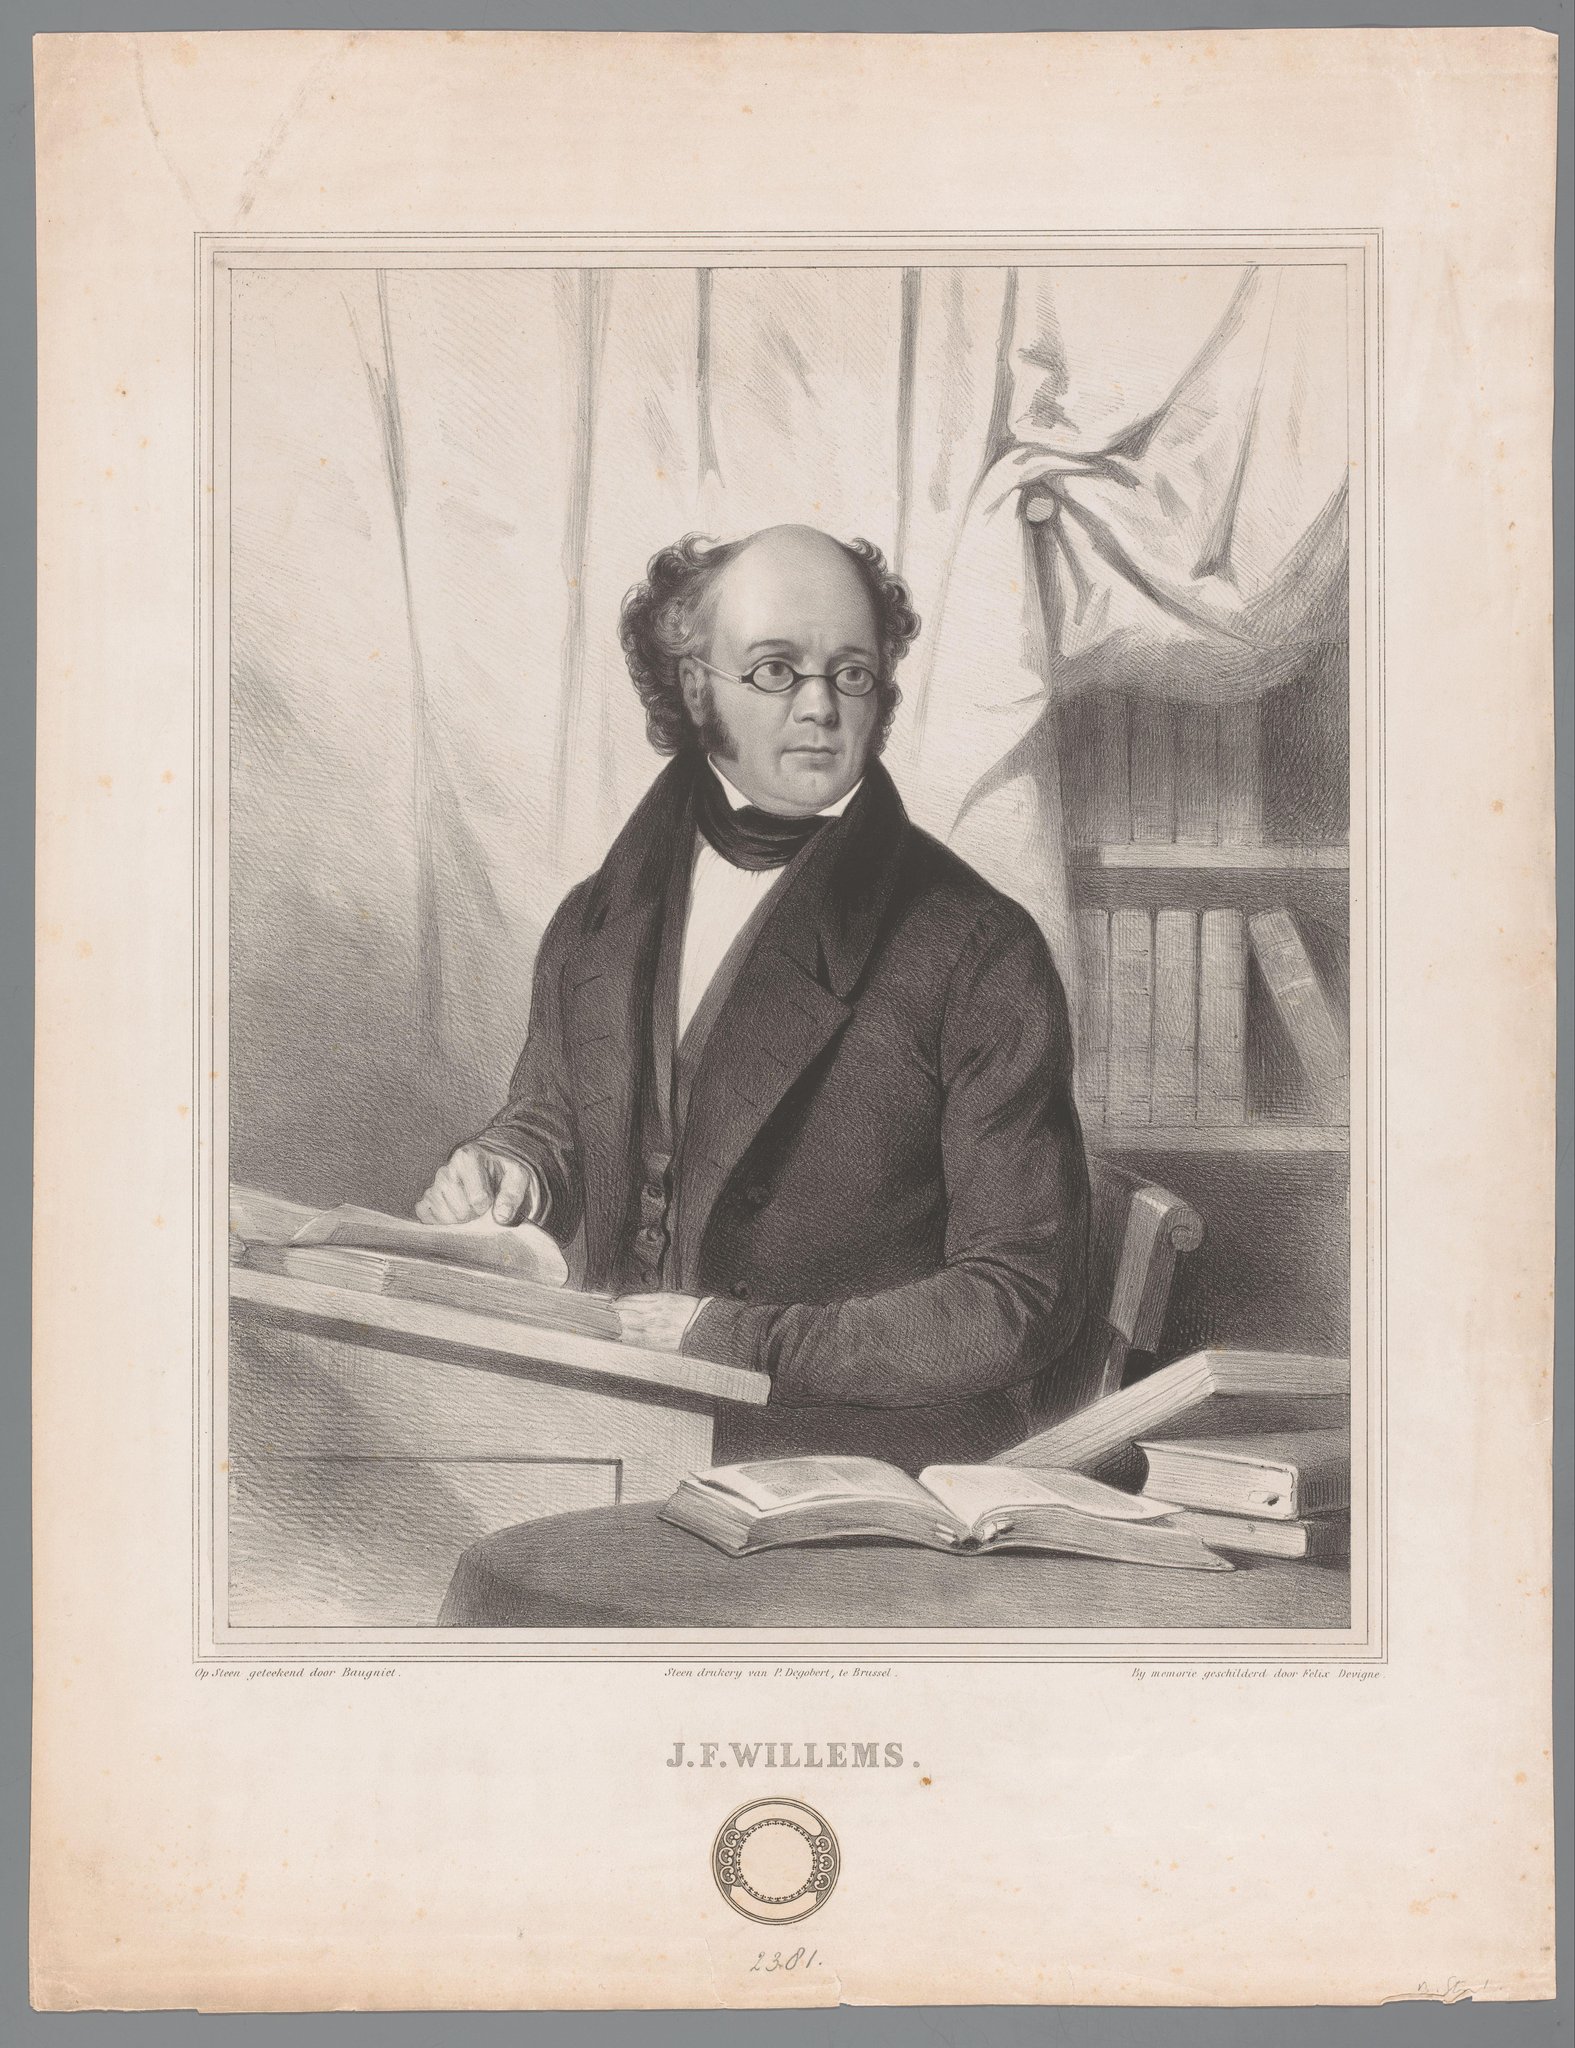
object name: print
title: Portret van Jan Frans Willems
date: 1824-1886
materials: paper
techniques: lithograph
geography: brussels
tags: ghent, eyeglasses, spectacles, adult man, historical persons, book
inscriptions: label, label: ‘M. (portr.) B, no 6079’, collector's mark: Lugt 2228